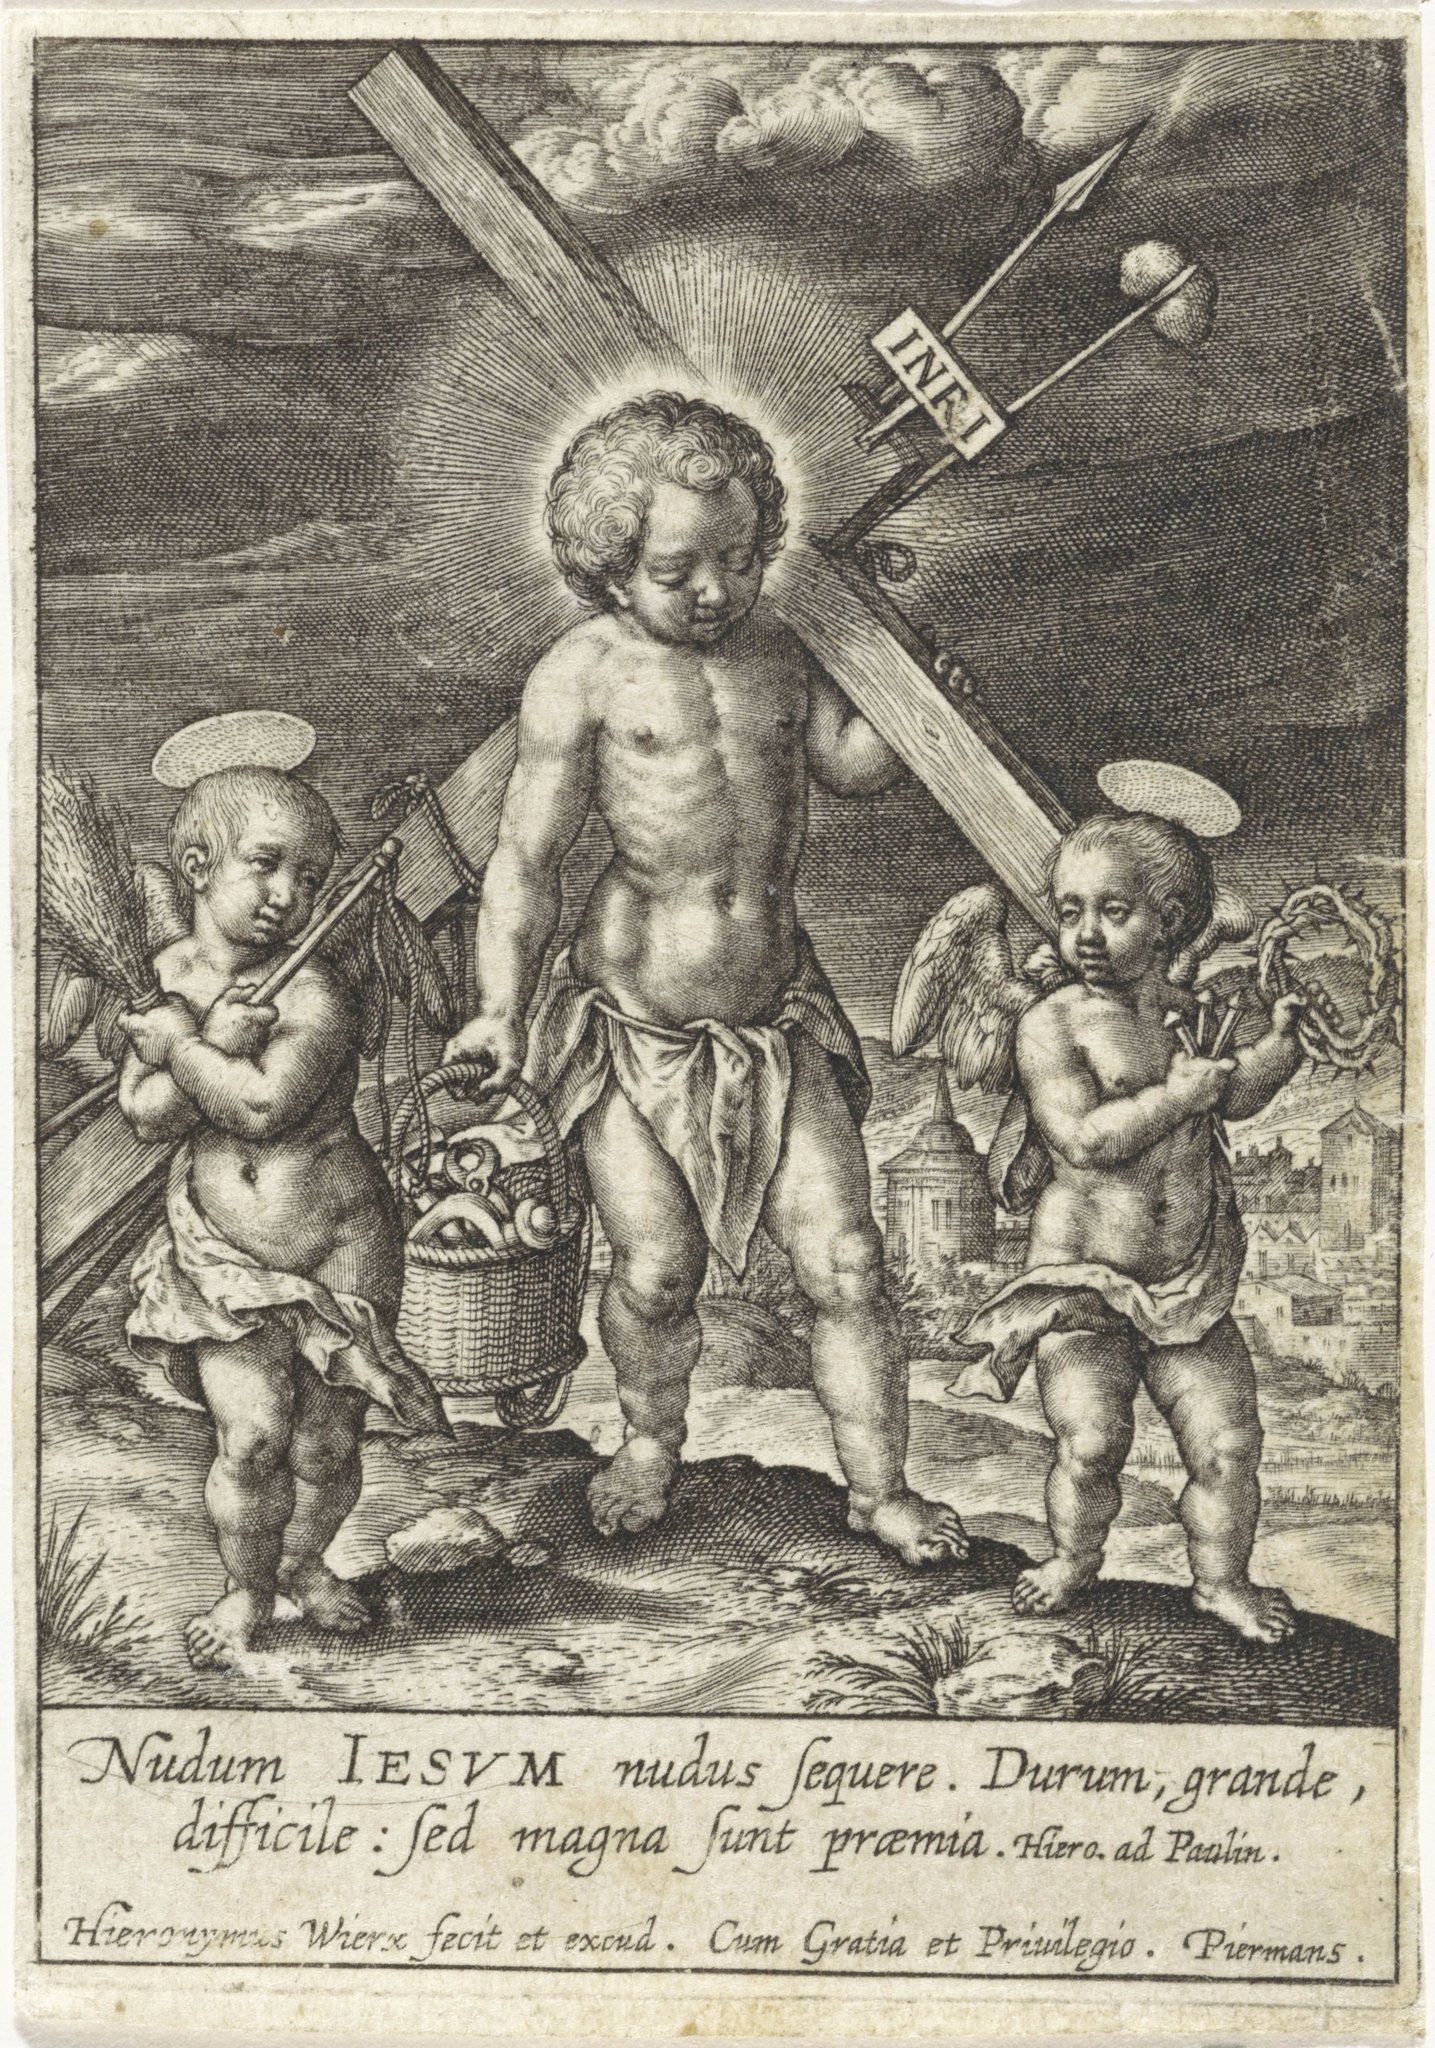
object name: print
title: Christuskind draagt de passiewerktuigen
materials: paper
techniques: engraving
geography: antwerp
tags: christ-child carrying the instruments of the passion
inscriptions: collector's mark: Lugt 2228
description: Het Christuskind draagt de passiewerktuigen op zijn rug en in een mandje. Het Kind wordt geflankeerd door engelen die nog meer passiewerktuigen dragen. In de marge een tweeregelig onderschrift in het Latijn.